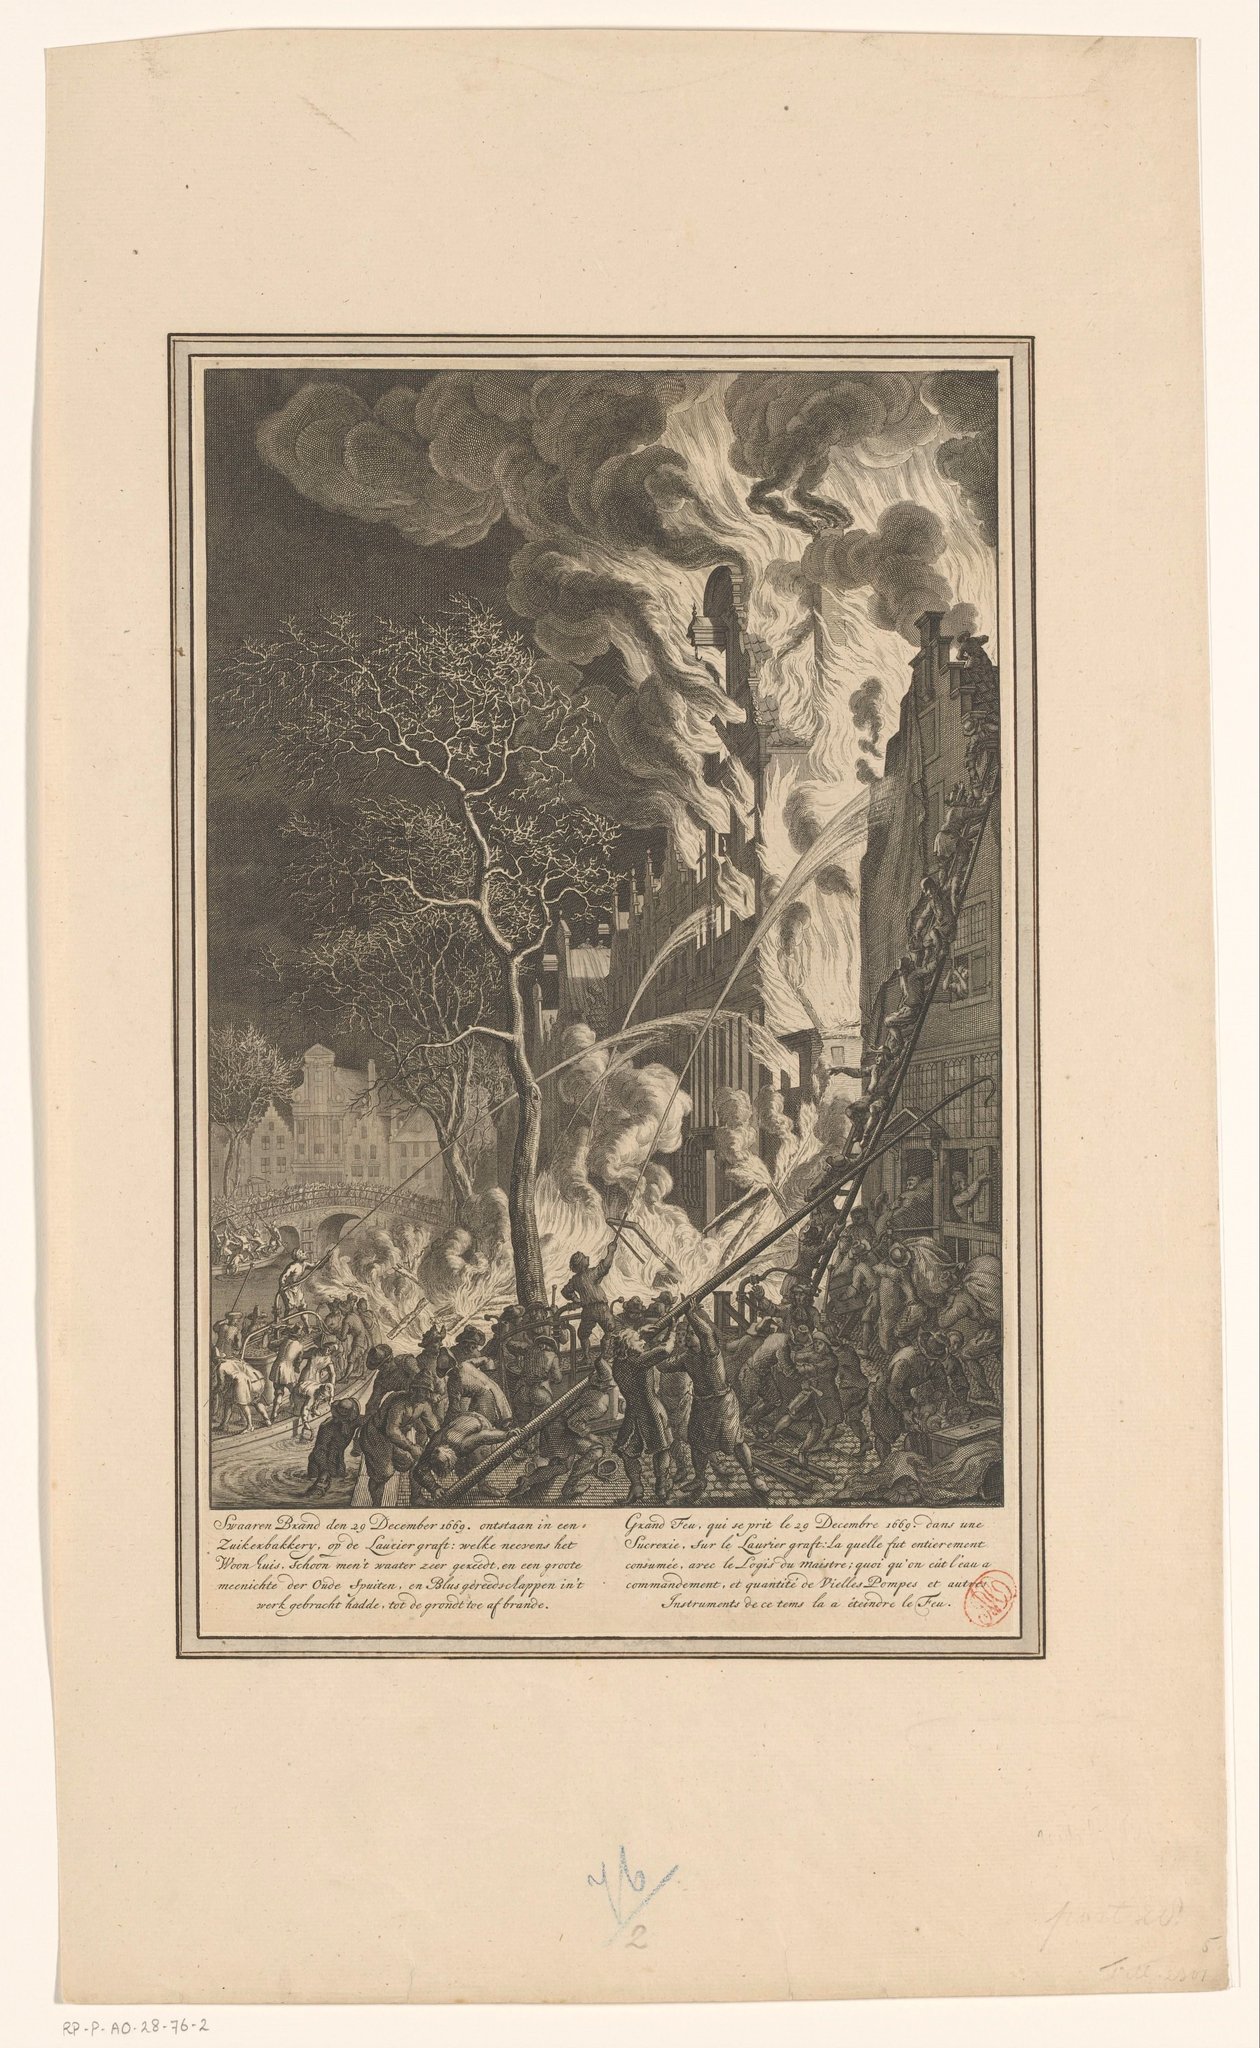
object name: book illustration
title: Brand op de Lauriergracht te Amsterdam, 1669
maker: jan van der heyden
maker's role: draughtsman, painter, print maker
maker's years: 1637-1712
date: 1690-1735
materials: paper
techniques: engraving, etching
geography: amsterdam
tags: painter, print maker, draughtsman, jan van der heyden, on fire, ablaze, fire-fighting, fire-extinguishing equipment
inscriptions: collector's mark: Lugt 195, collector's mark: Lugt 2228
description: Prent ook gebruikt in: Heyden, Jan van der. Beschryving der nieuwlyks uitgevonden en geoctrojeerde slang-brand-spuiten en haare wyze van brand-blussen, tegenwoordig binnen Amsterdam in gebruik zijnde (…). 1e druk. Amsterdam: Jan Rieuwertsz. (II), 1690. En in: Heyden, Jan van der. Beschryving der nieuwlyks uitgevonden en geoctrojeerde slang-brand-spuiten en haare wyze van brand-blussen, tegenwoordig binnen Amsterdam in gebruik zijnde (…). 2e druk. Amsterdam: erfgenamen Jan van der Heyden, 1735. Voor eerdere staat (voor de letter) zie RP-P-1944-234.